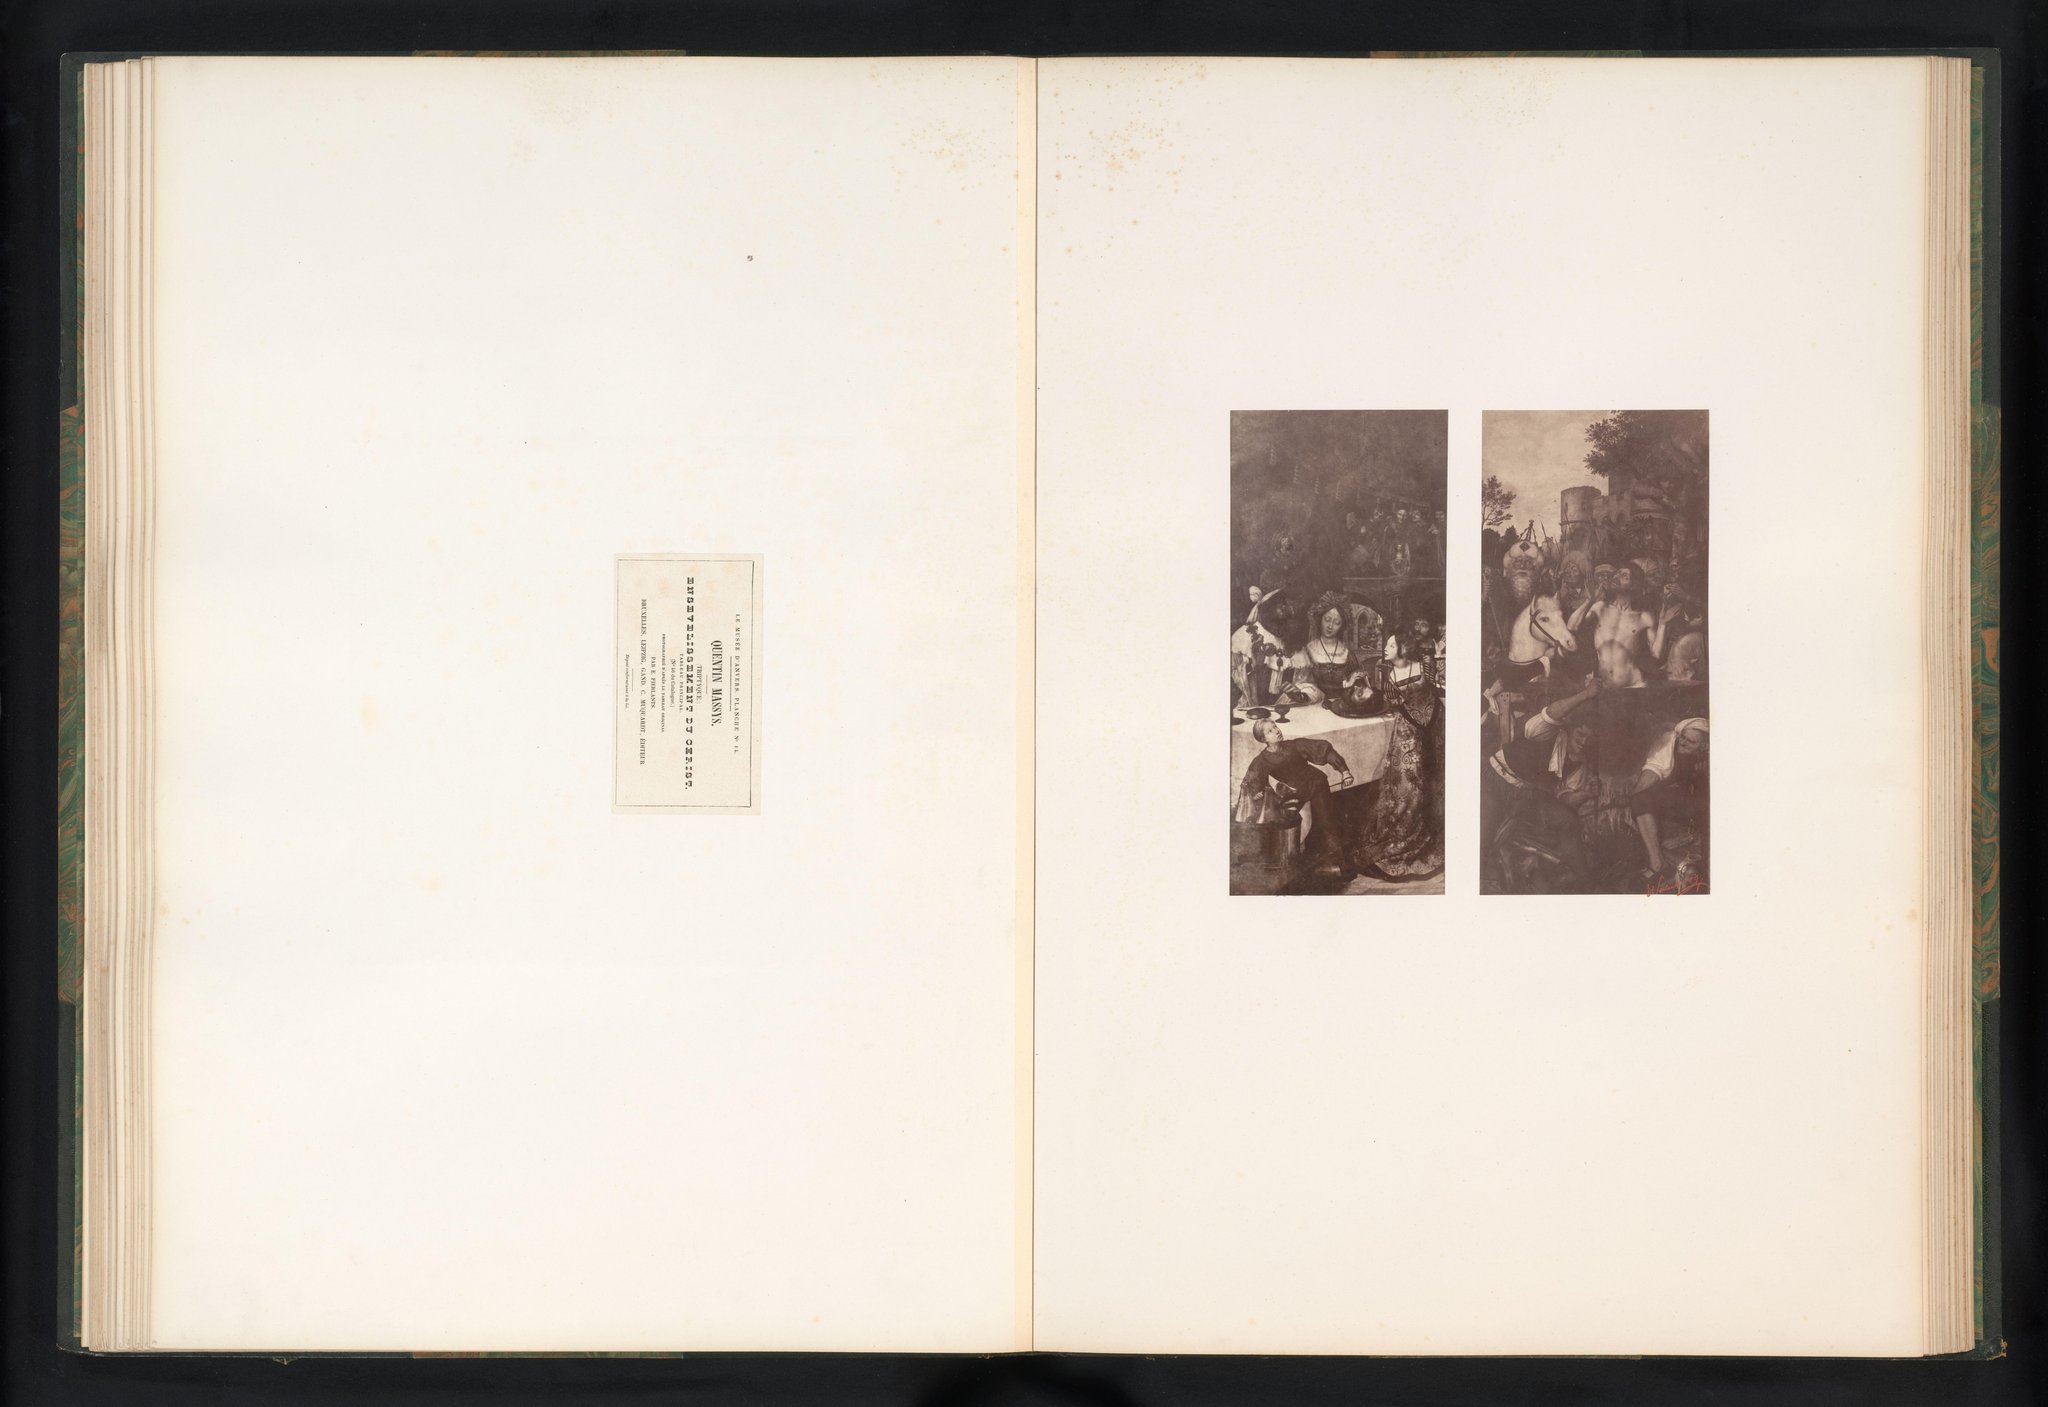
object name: page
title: Fotoreproducties van de Onthoofding van Johannes de Doper en van de Heilige Johannes in de olie door Quinten Massijs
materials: photographic support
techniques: albumen print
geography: brussels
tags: martyrdom and death of john the baptist (matthew 14:3-12; mark 6:17-29)